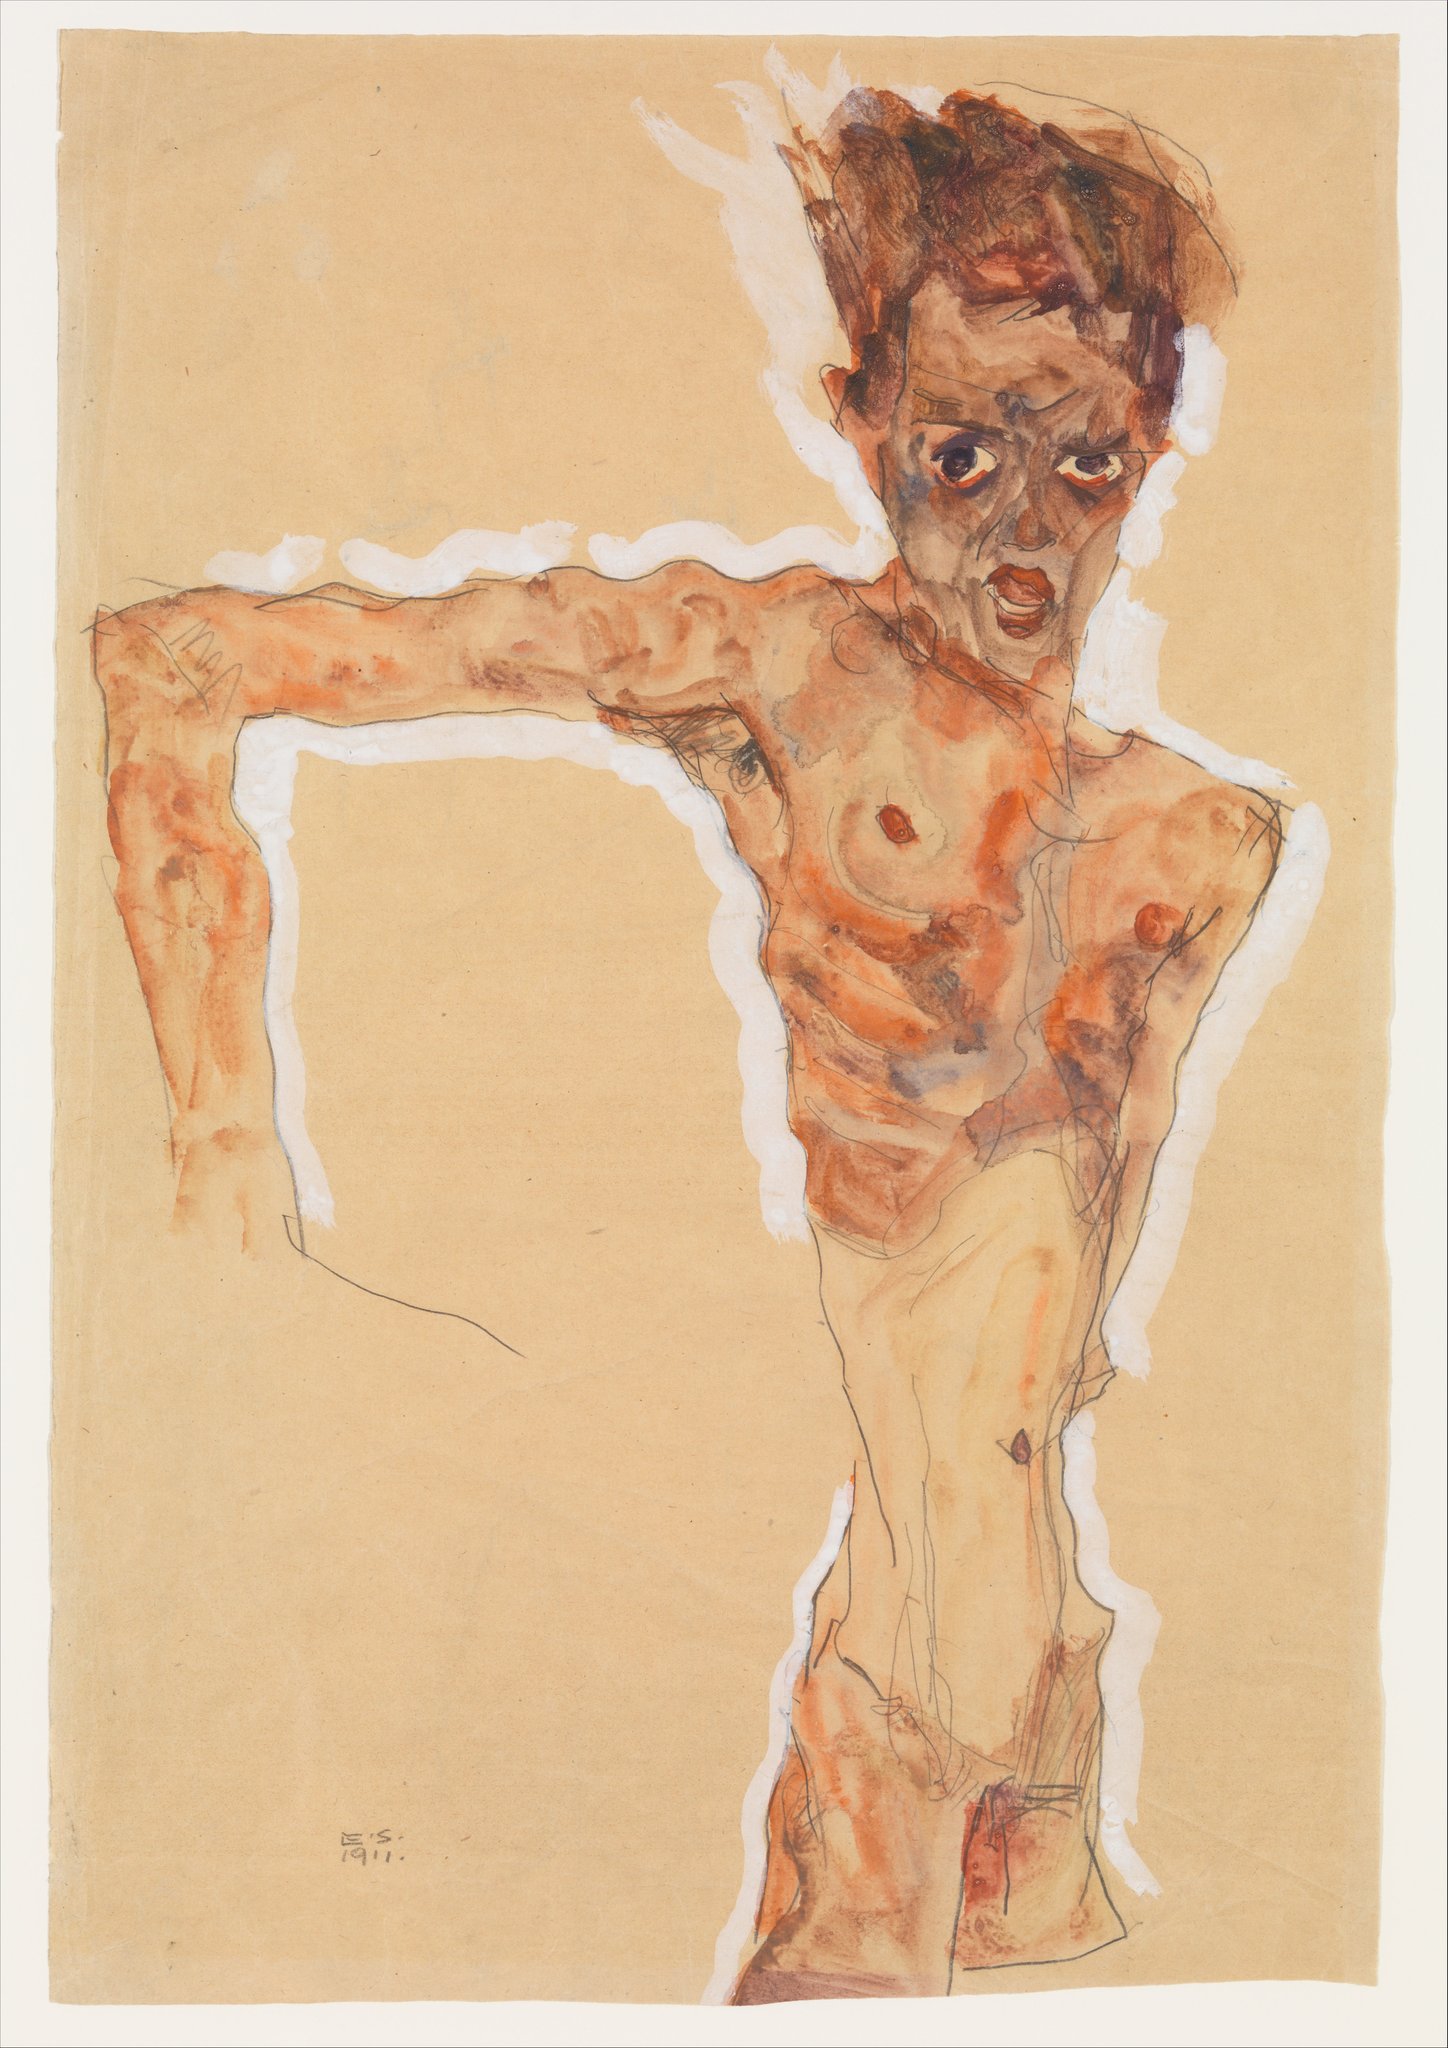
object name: drawing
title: Self-Portrait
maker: egon schiele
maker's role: artist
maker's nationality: austrian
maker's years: 1890-1918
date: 1911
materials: graphite, paper, watercolor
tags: male nudes,self-portraits